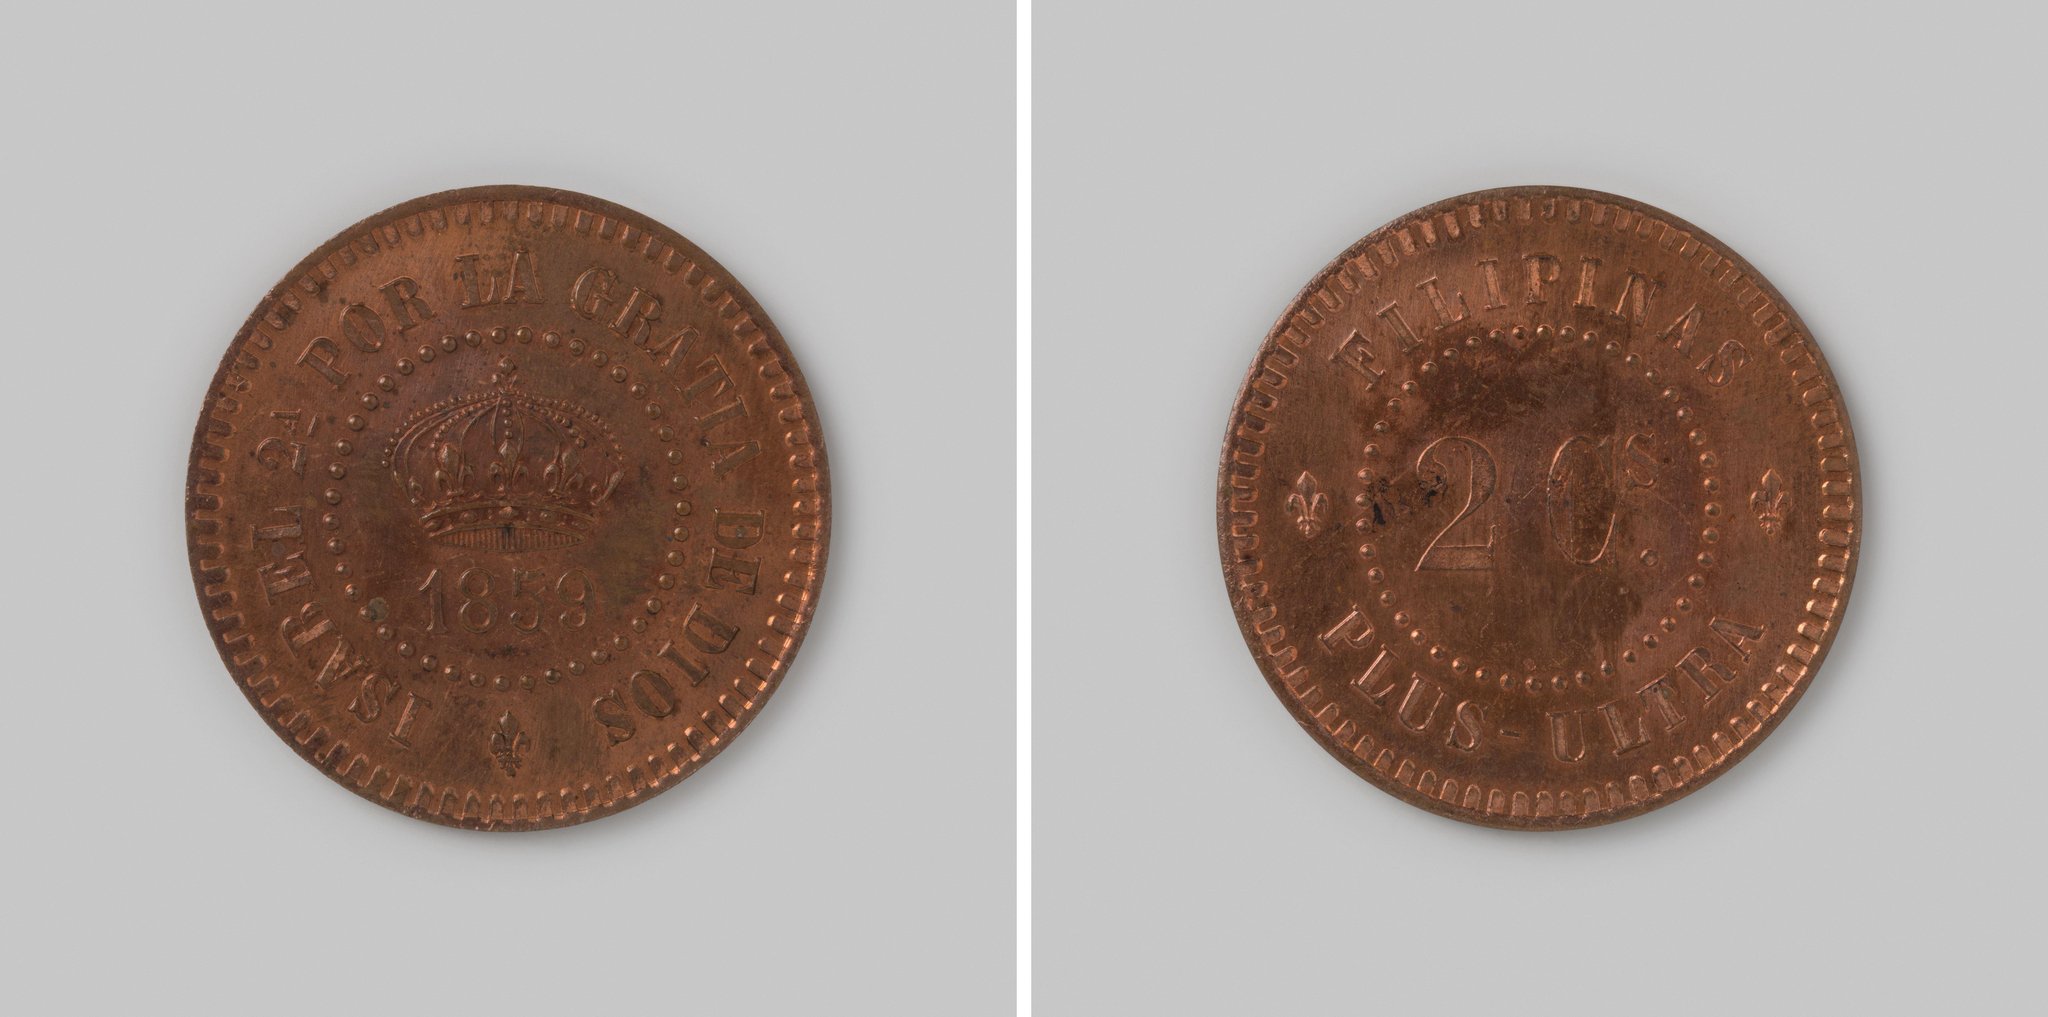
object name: coin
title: Philippijnen, koningin Isabel II van Spanje, 2 centimos [= 1/50 real de vellon van Spanje), 1859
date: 1859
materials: copper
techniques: striking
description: Koperen munt. Voorzijde: binnen cirkel kroon, waaronder jaartal. Keerzijde: binnen cirkel waarde-aanduiding: 2 Cs. In omschrift bovenaan: Filipinas. Gladde rand.